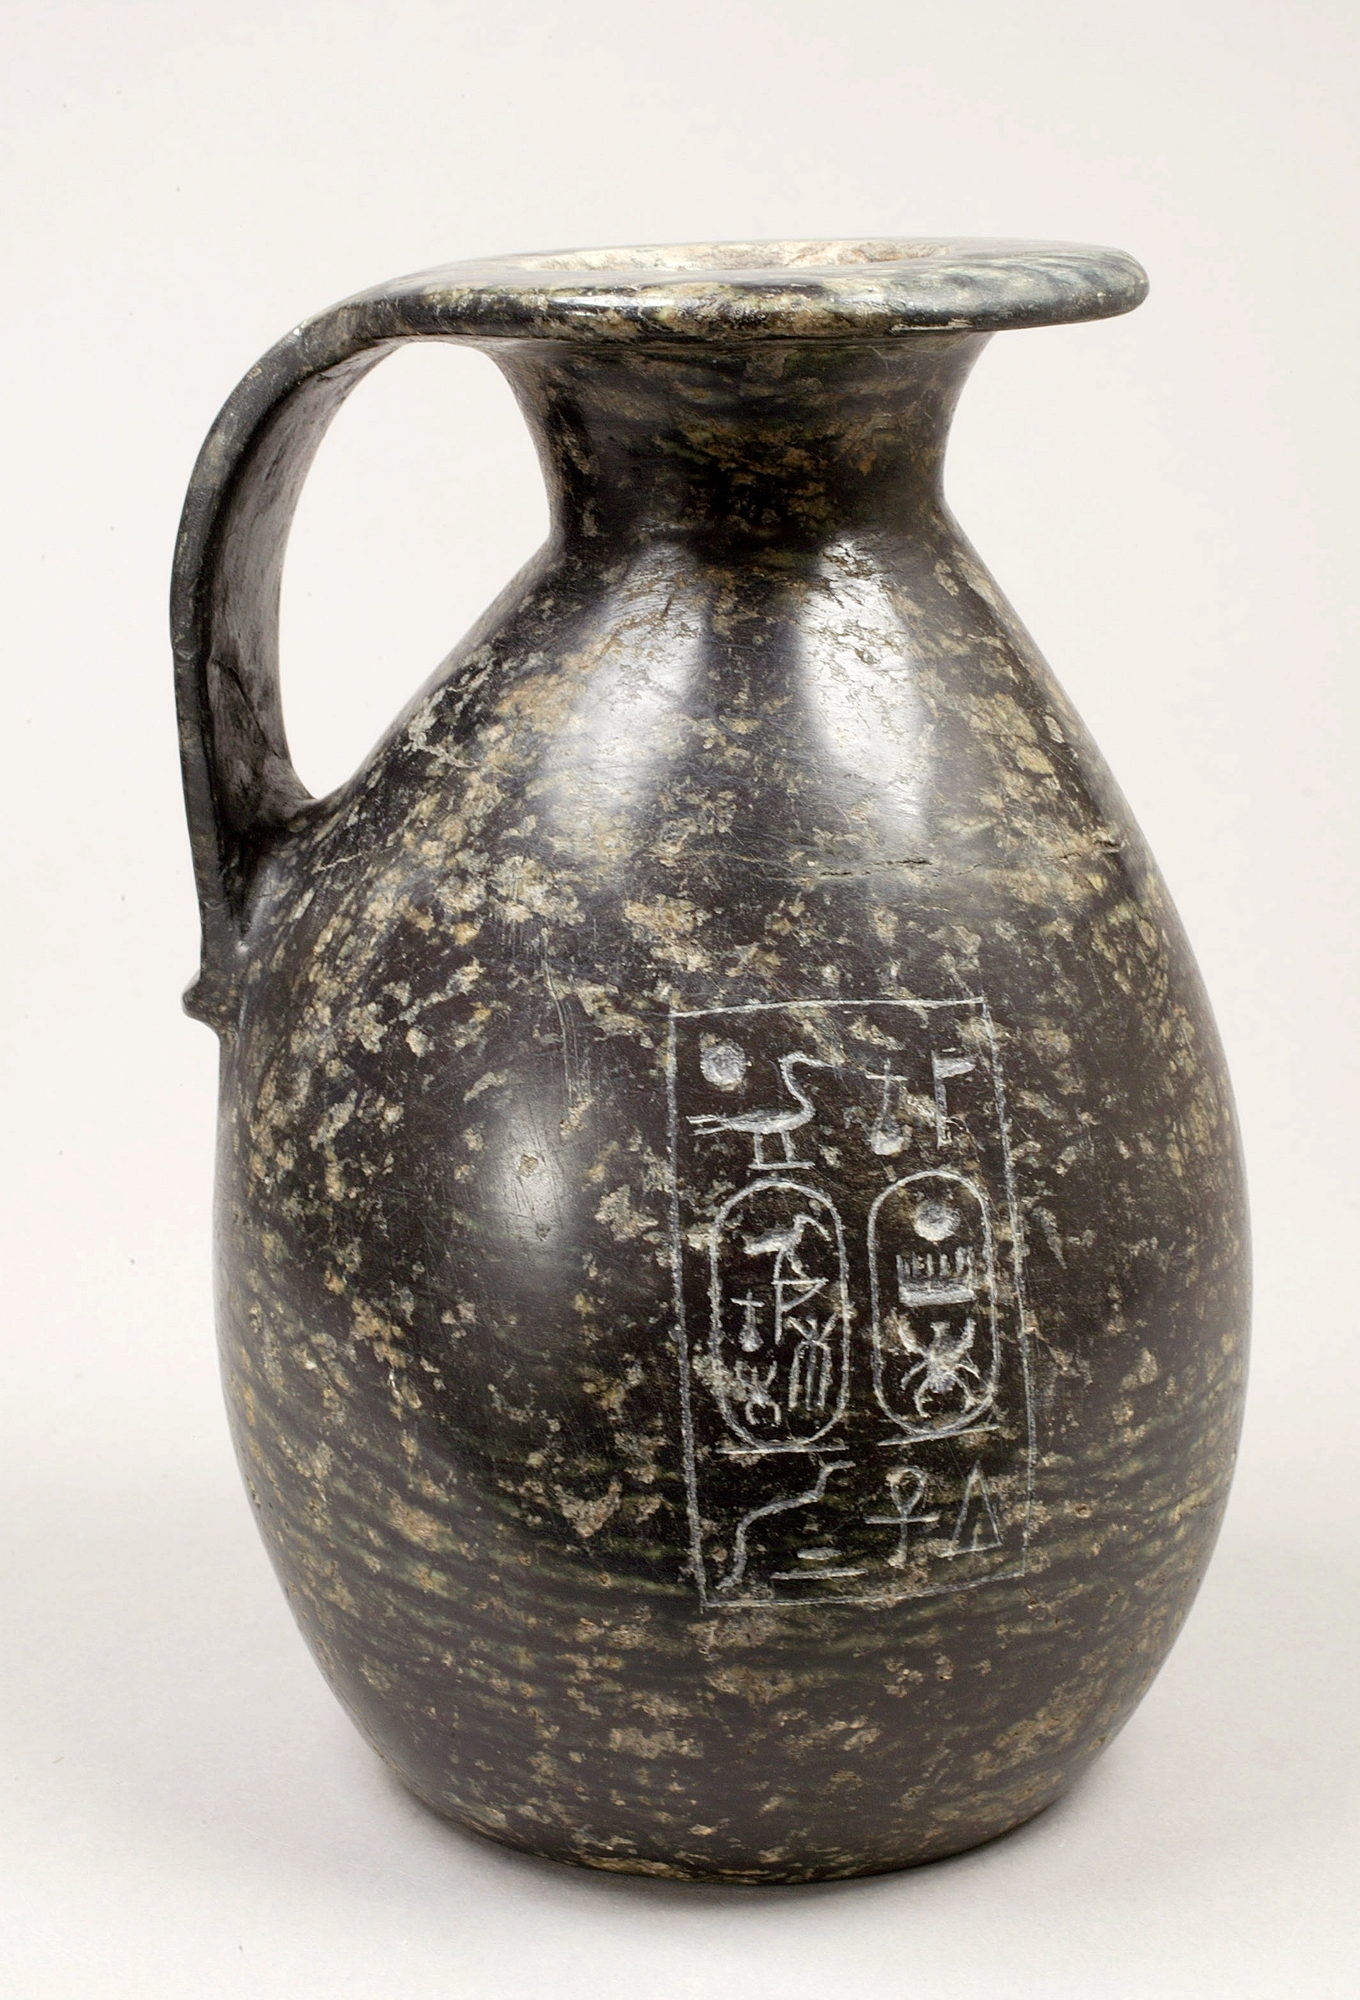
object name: jug, piriform, thutmose iii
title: Piriform jug with cartouche of Thutmose III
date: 1479-1425 BCE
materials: stone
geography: egypt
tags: cartouches,hieroglyphs